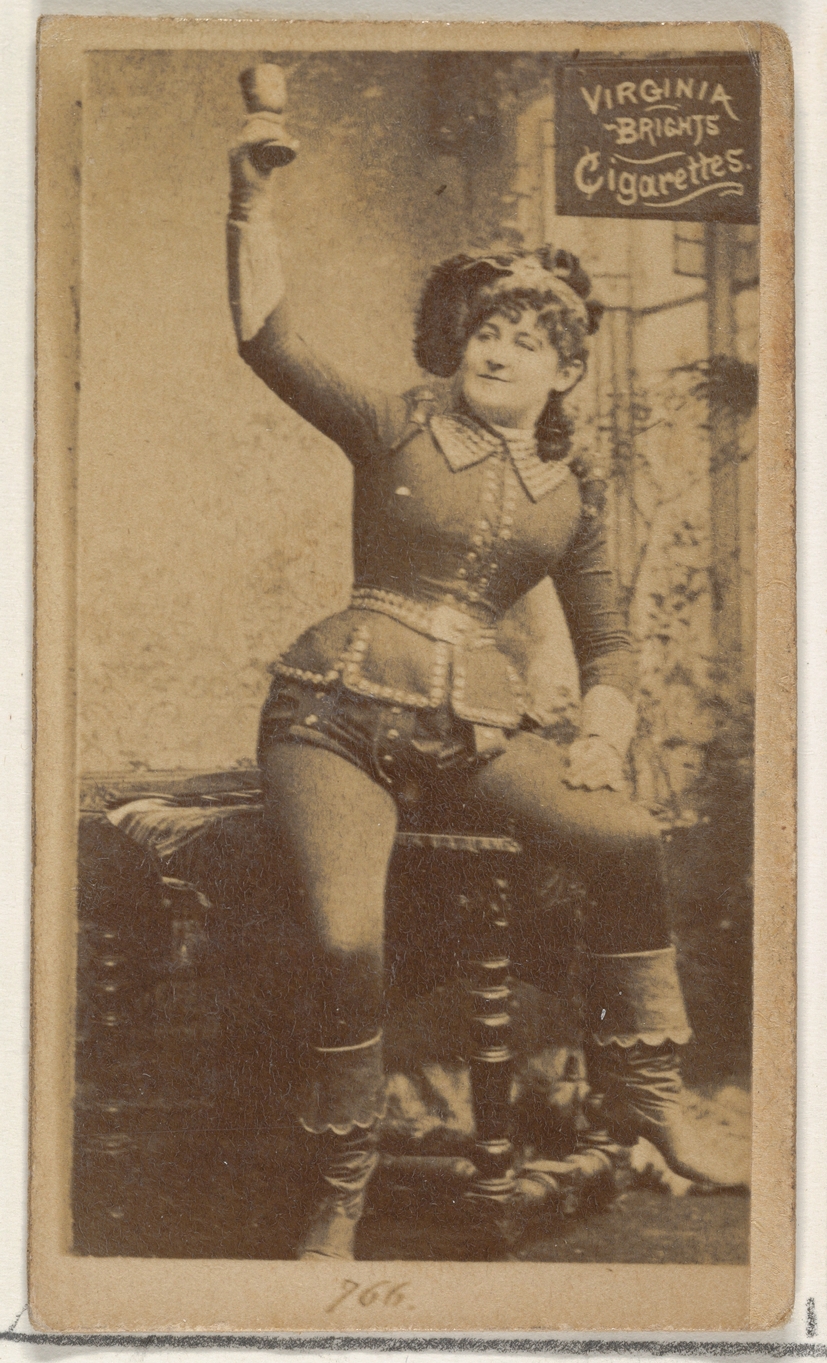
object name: photograph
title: Card 766, from the Actors and Actresses series (N45, Type 2) for Virginia Brights Cigarettes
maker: allen & ginter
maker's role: publisher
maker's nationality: american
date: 1888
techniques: albumen silver print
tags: portraits,women,actresses